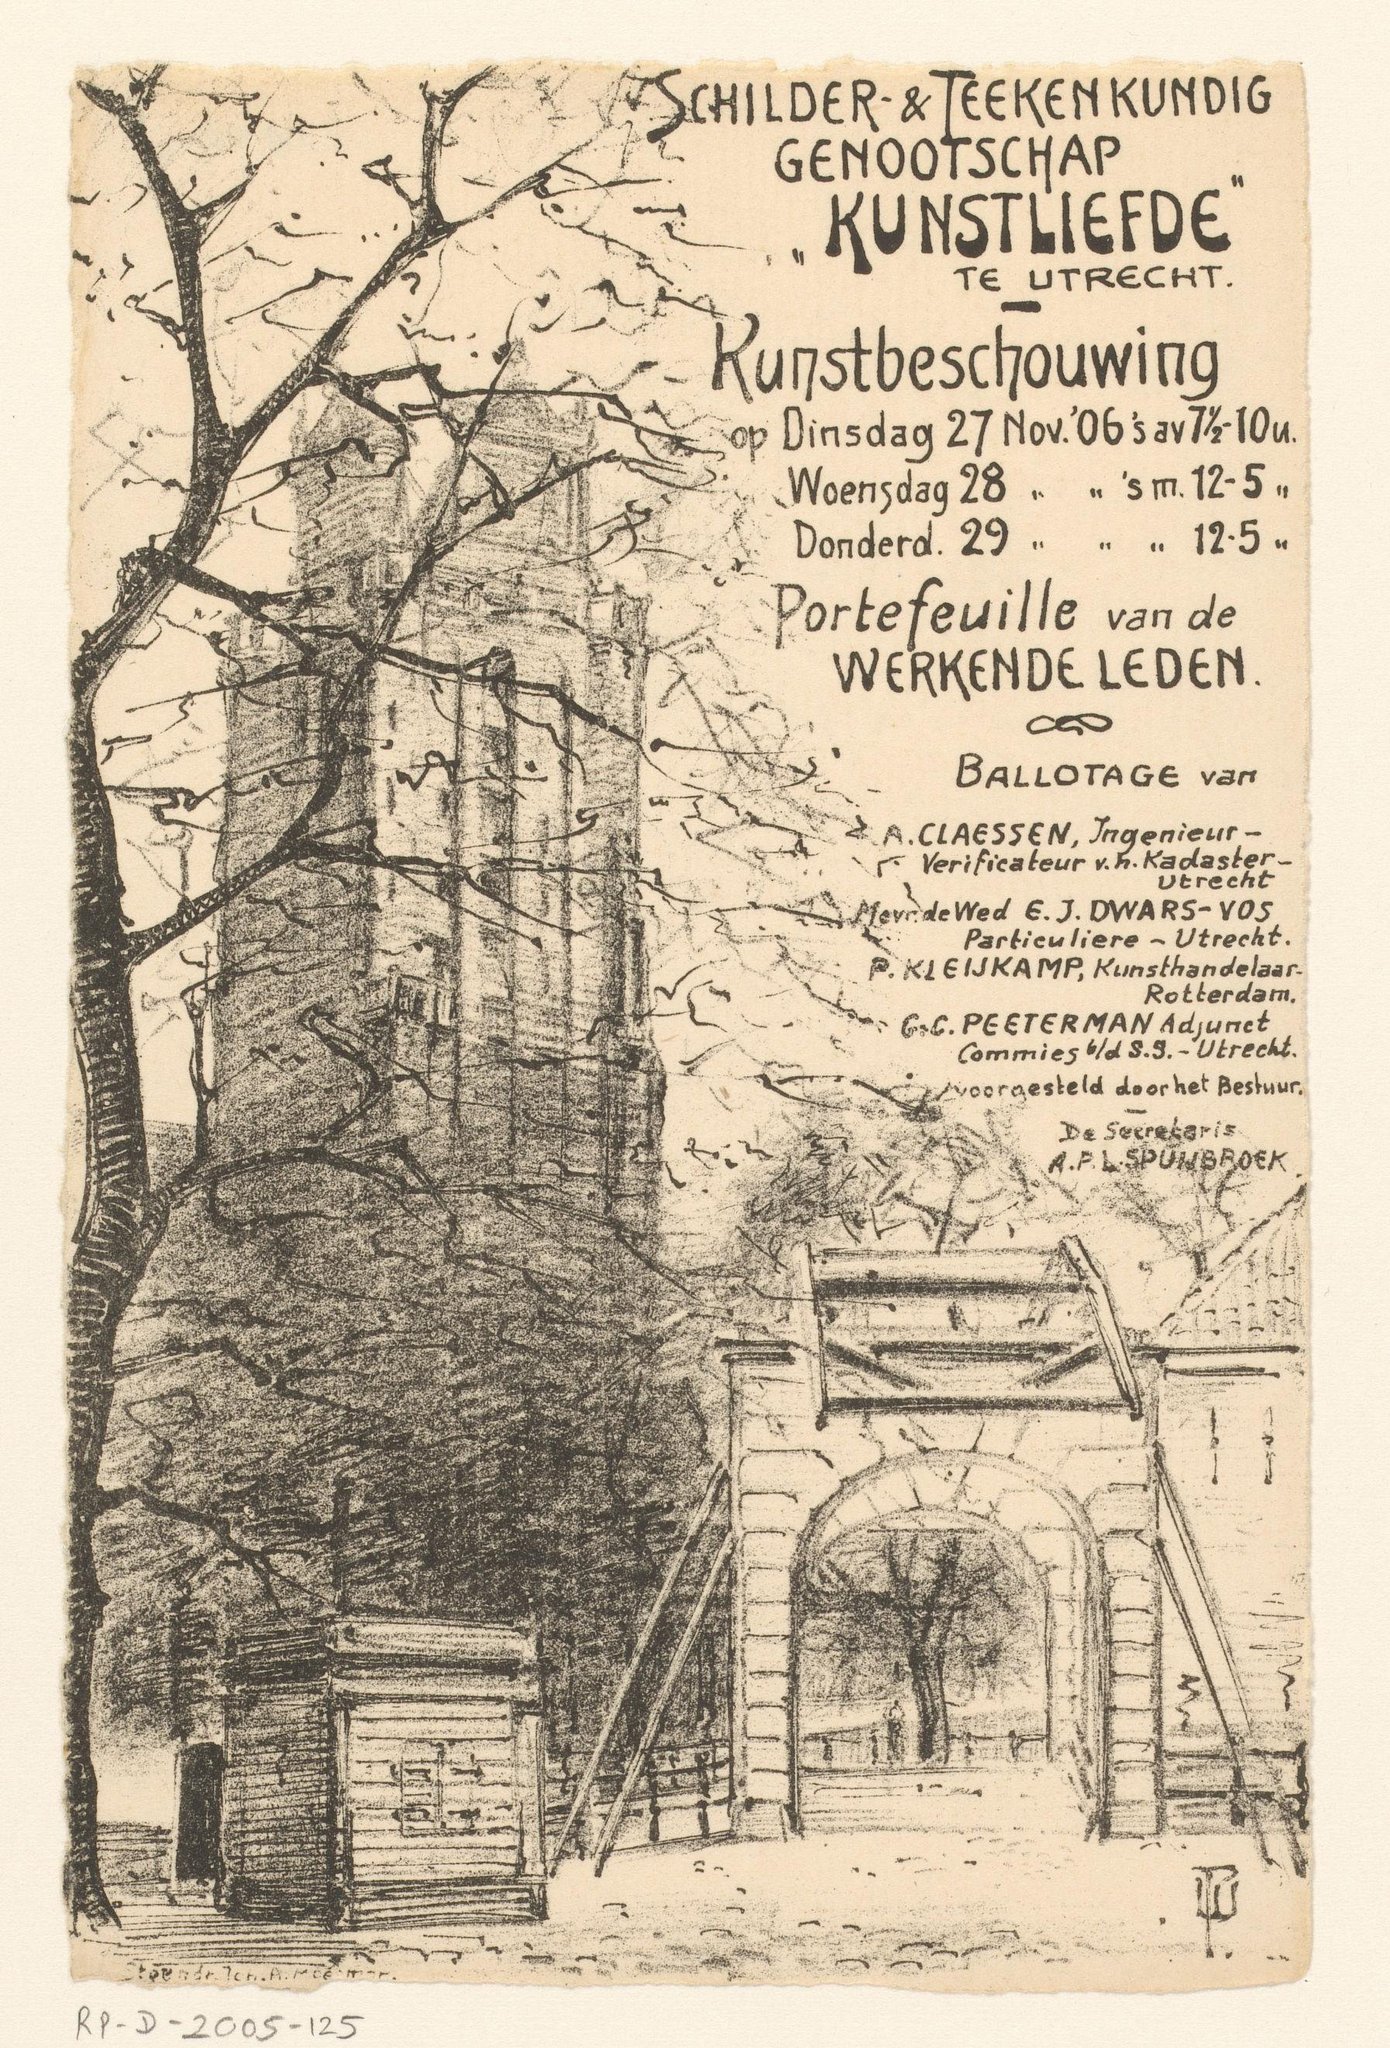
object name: print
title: Uitnodiging van Schilder- en Teekenkundig Genootschap "Kunstliefde" voor een kunstbeschouwing, 27, 28 en 29 november 1906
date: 1906-1911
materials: paper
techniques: lithograph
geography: utrecht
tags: criticizing and discussing art, art criticism, circle, club of artists, collecting and exhibiting products of the fine arts, church (exterior)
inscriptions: collector's mark: Lugt 2228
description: Dom te Utrecht. Uitnodiging van Schilder- en Teekenkundig Genootschap "Kunstliefde" voor een kunstbeschouwing op 27-29 november 1906 van de portefeuille van de werkende leden.